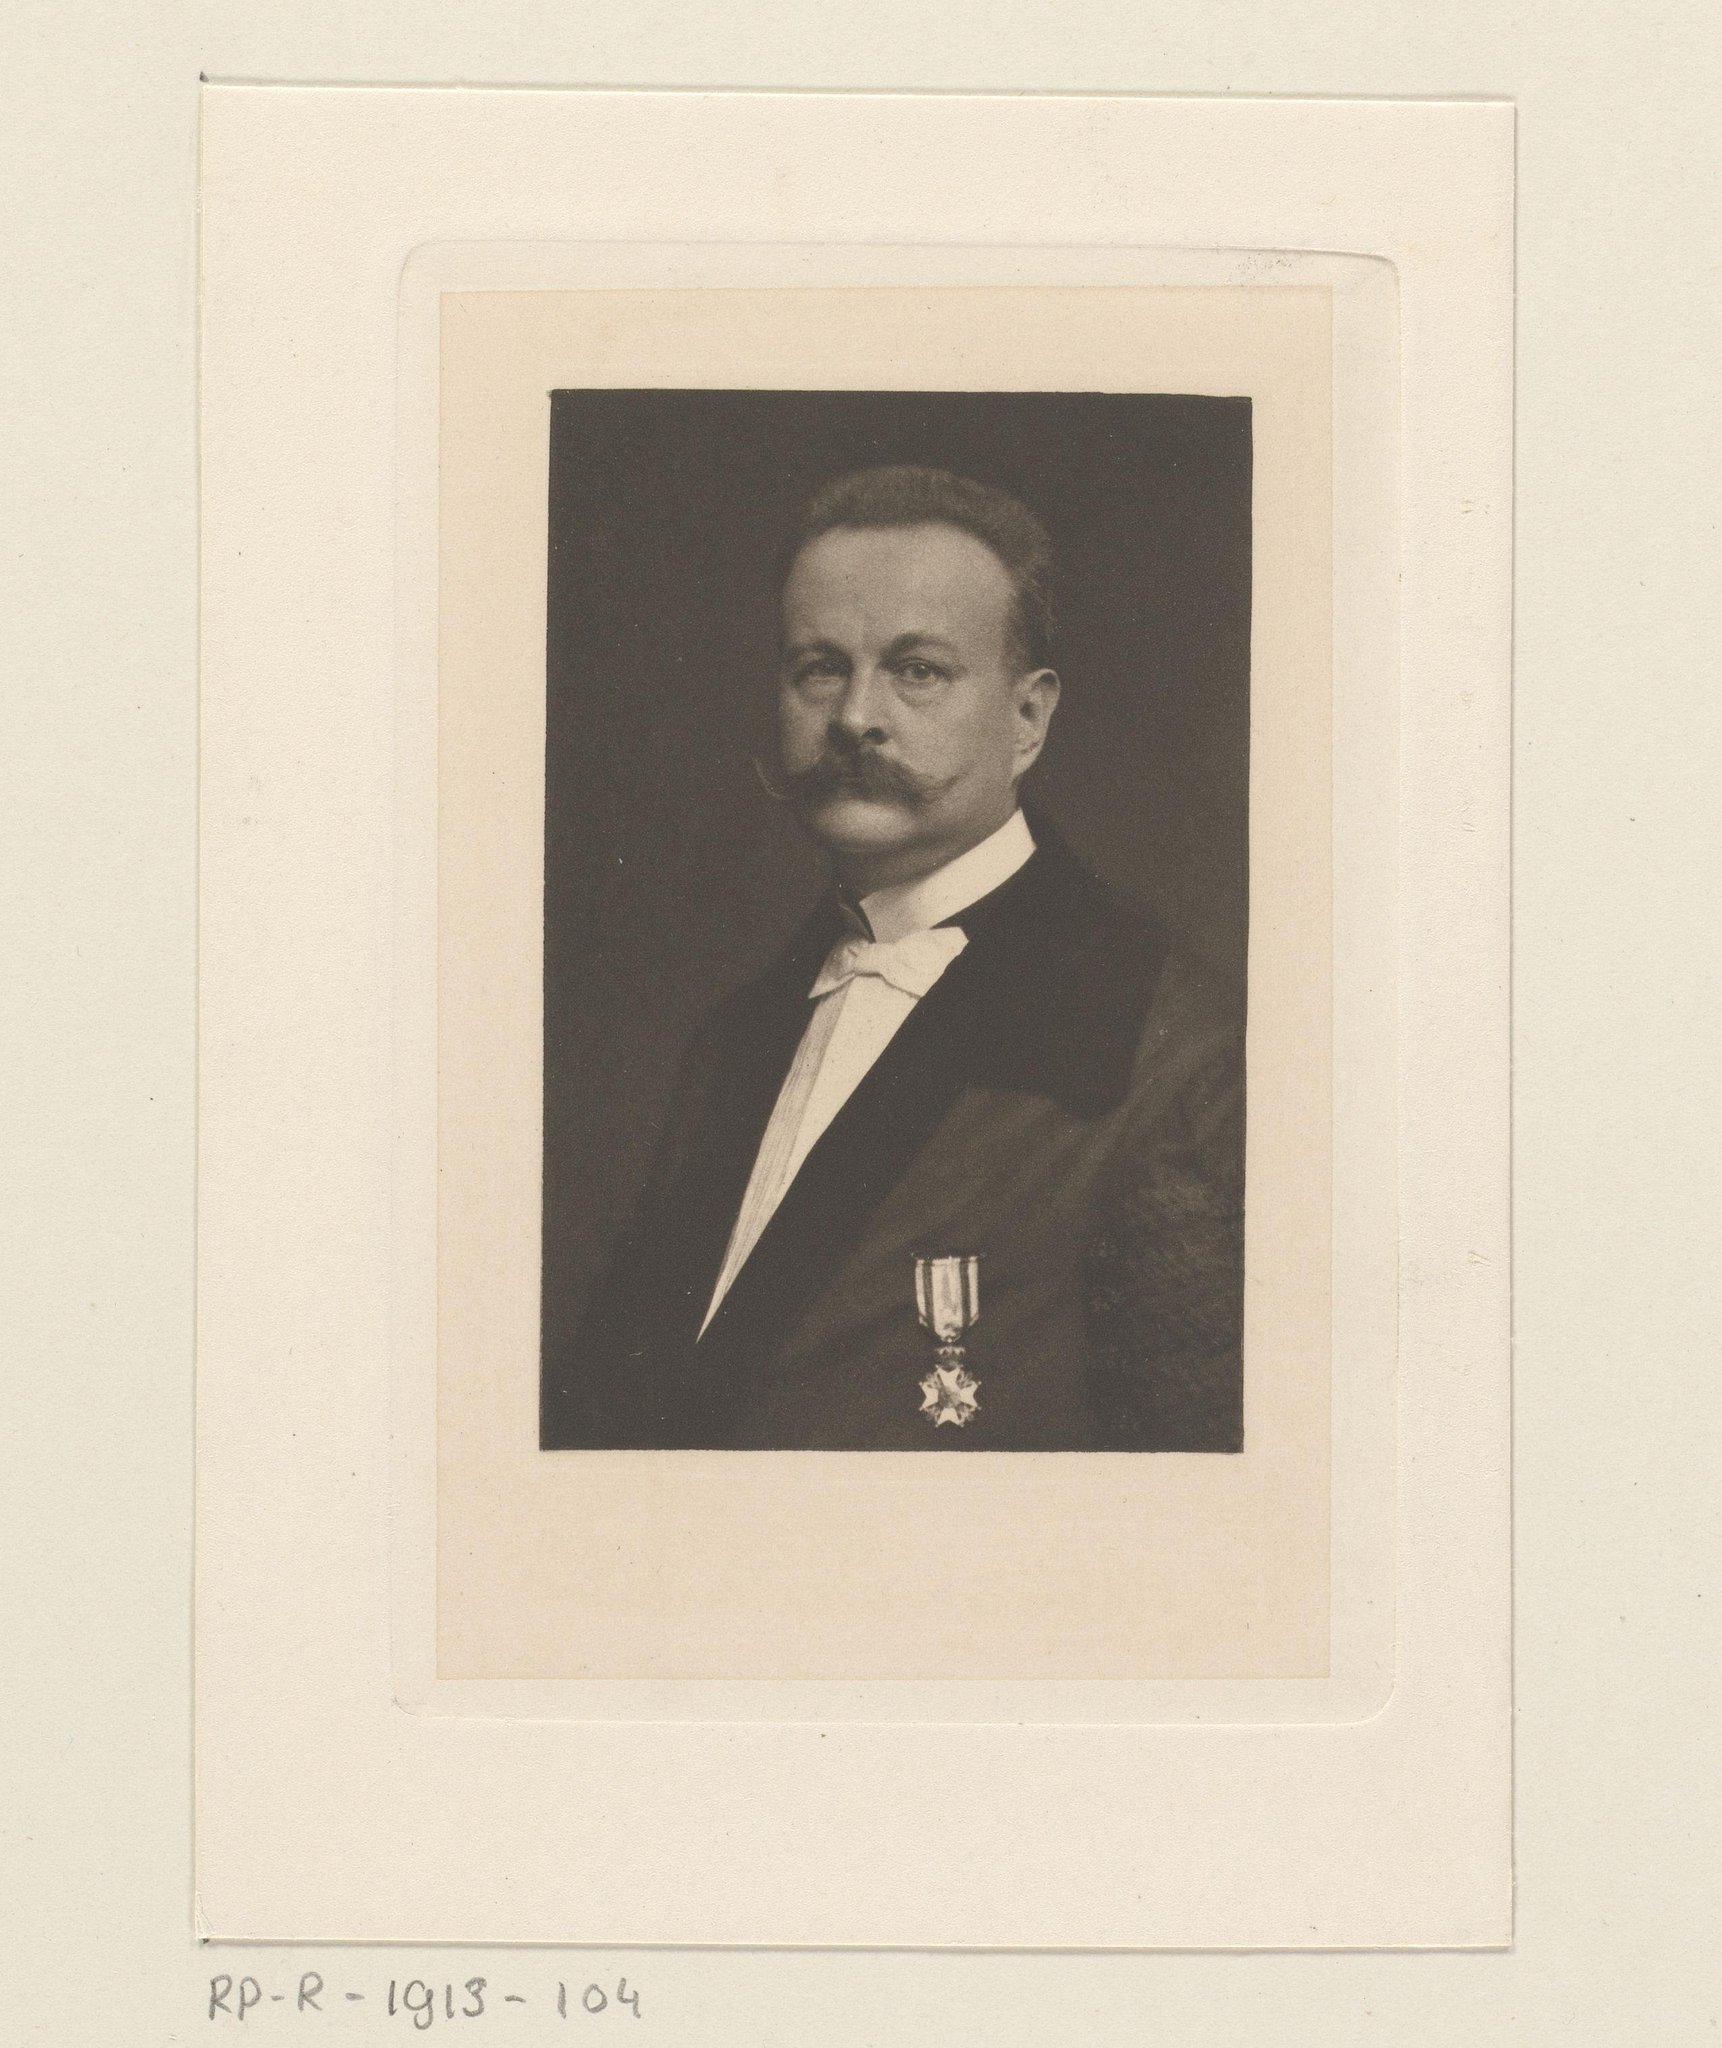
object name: photomechanical print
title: Portret van Henri du Bois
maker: Anonymous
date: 1900-1910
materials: paper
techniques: photoaquatint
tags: utrecht, historical persons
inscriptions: collector's mark: Lugt 2228a, inscription: ‘Prof dr. H.J.E.G. du Bois/ oud-Hoogleraar/ der [...] Berlijn/ Nederl. Patriciaat/ N 1913’